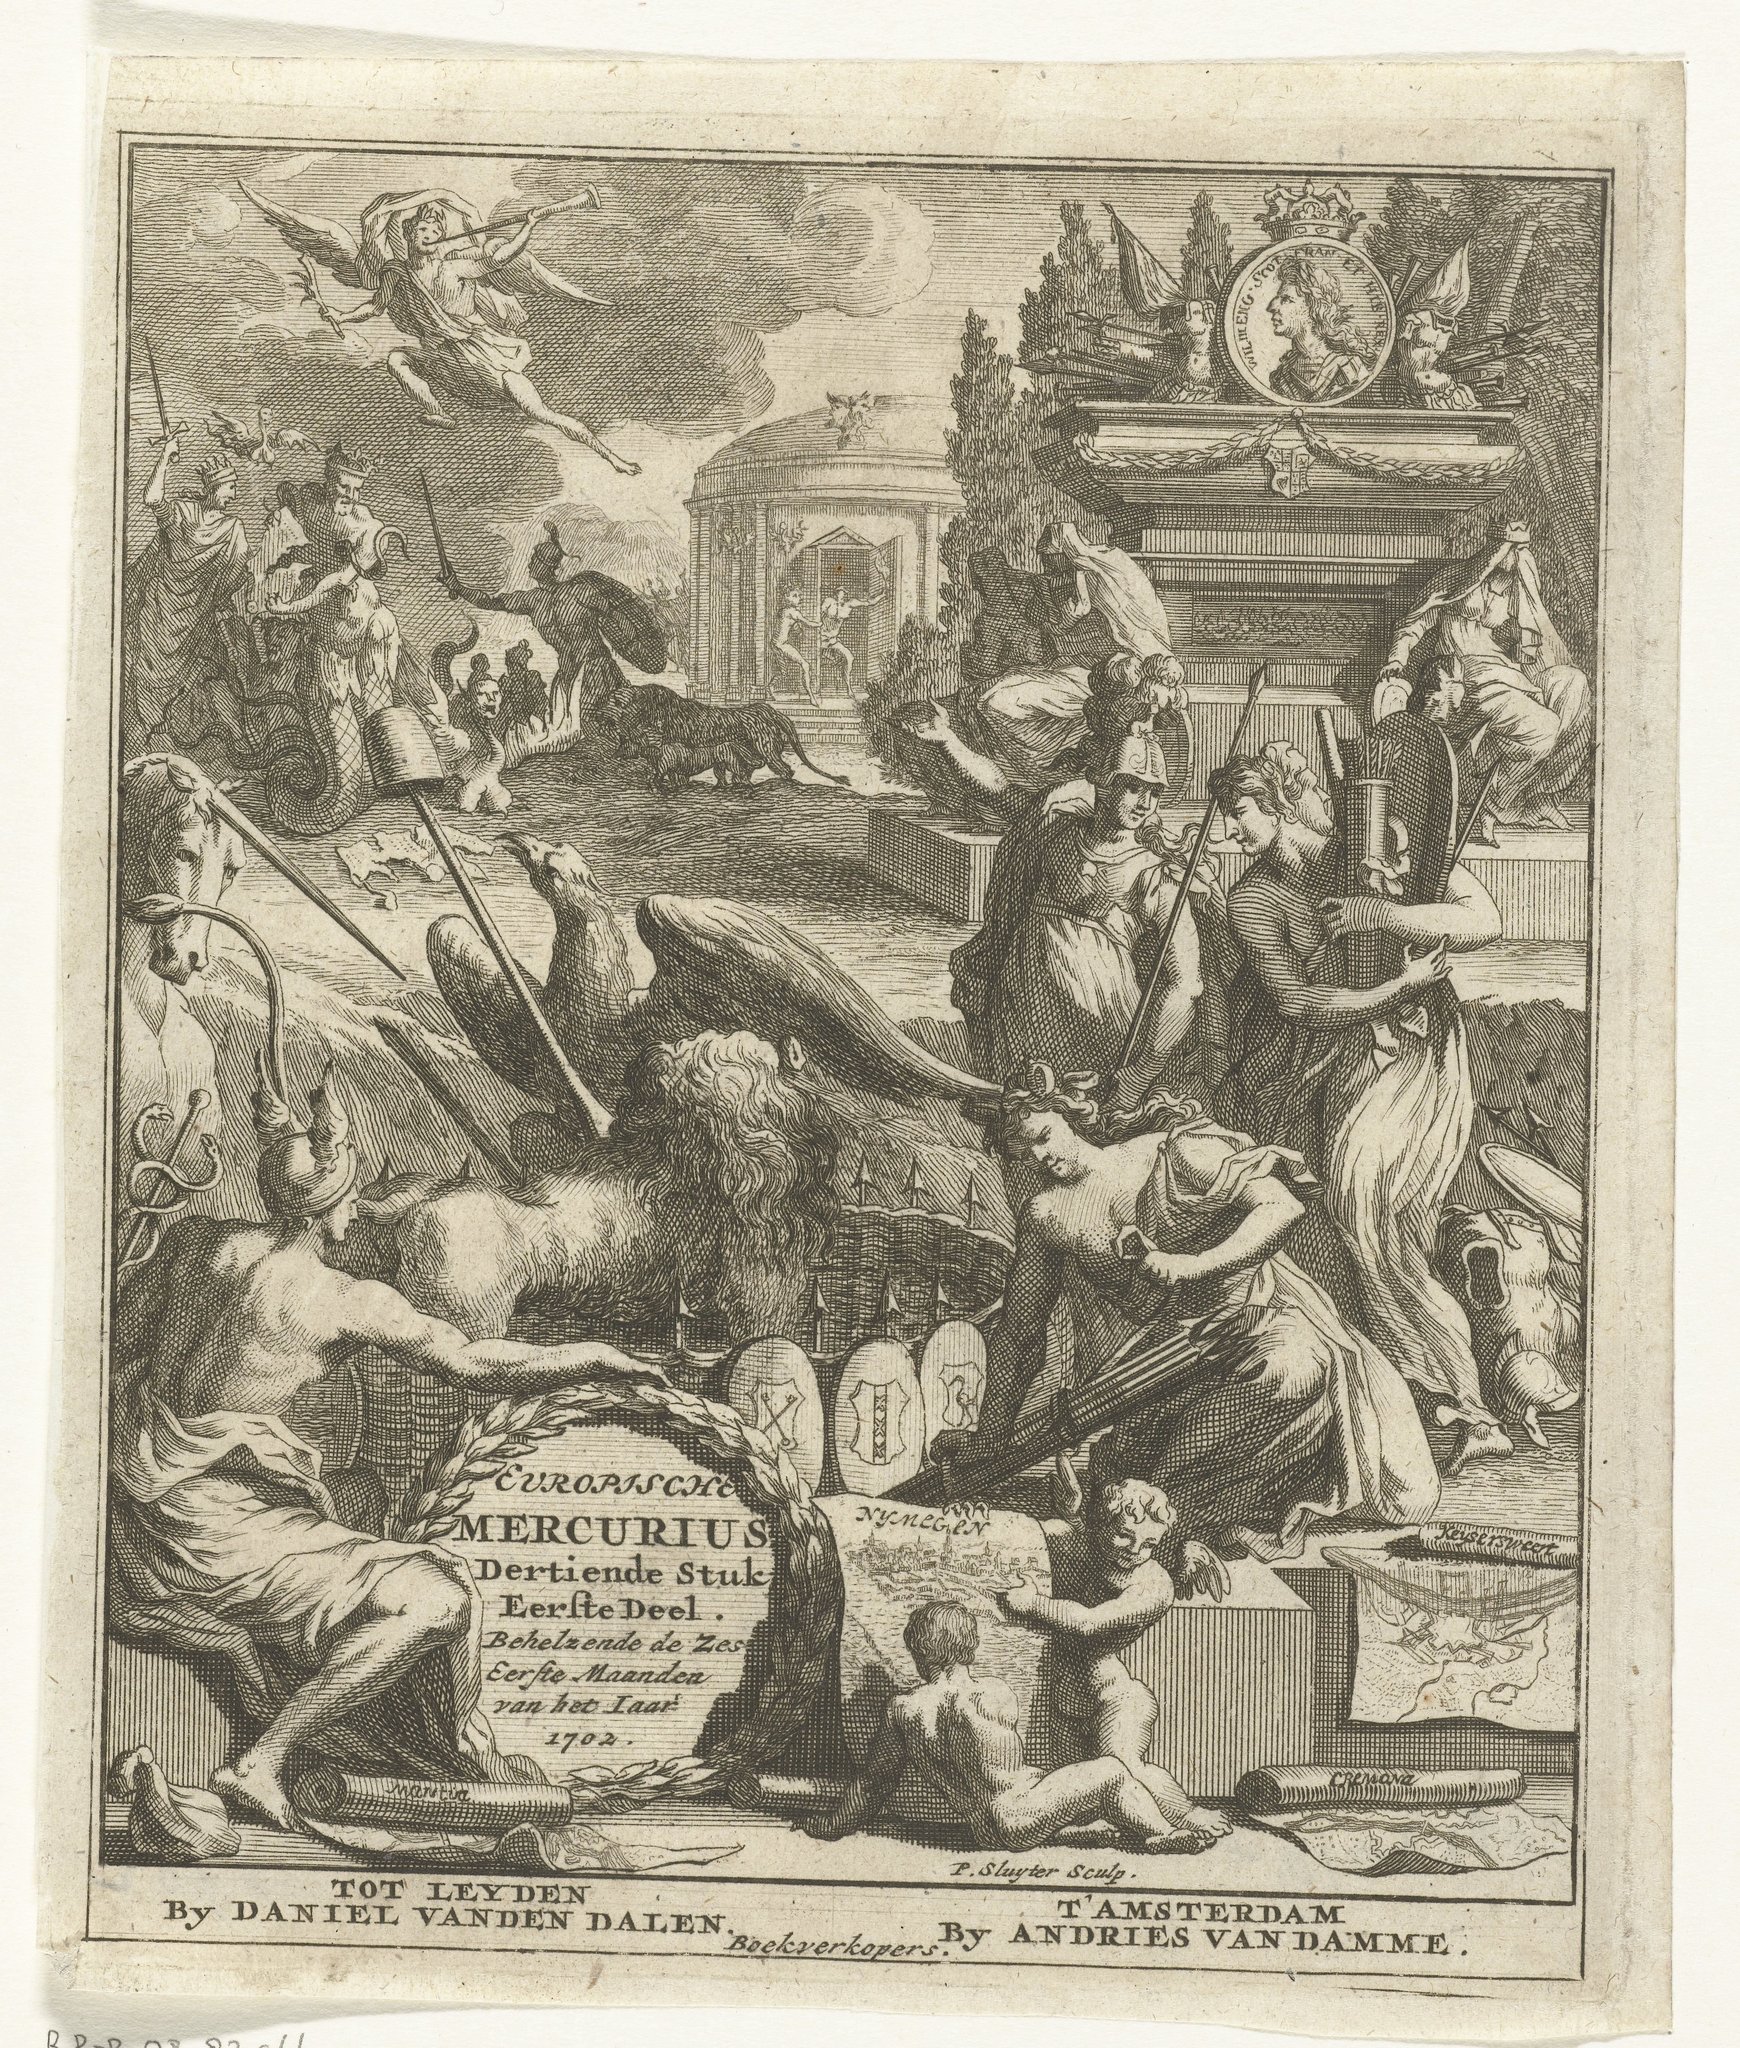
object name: titelblad, titelpagina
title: Europische Mercurius, Dertiende Stuk Eerste Deel. Behelzende de Zes Eerste Maanden van het Jaar 1702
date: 1702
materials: paper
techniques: etching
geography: amsterdam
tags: the hague, william iii (prince of orange and king of england, scotland, and ireland), fenced or walled garden; 'hortus conclusus', specific aspects, allegorical aspects of mercury; mercury as patron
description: Titelblad voor de Europische Mercurius van 1702. De Hollandse Tuin met de Hollandse Leeuw, buiten de omheining Mercurius met andere allegorische figuren en dieren. Rechts op de achtergrond een grafmonument voor Willem III.